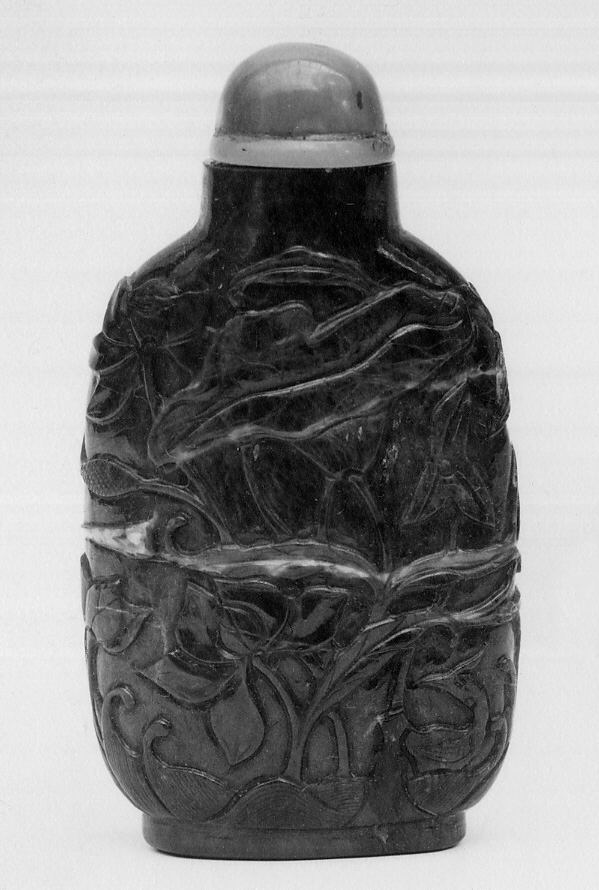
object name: snuff bottle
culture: chinese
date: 1801-1900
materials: coral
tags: flowers